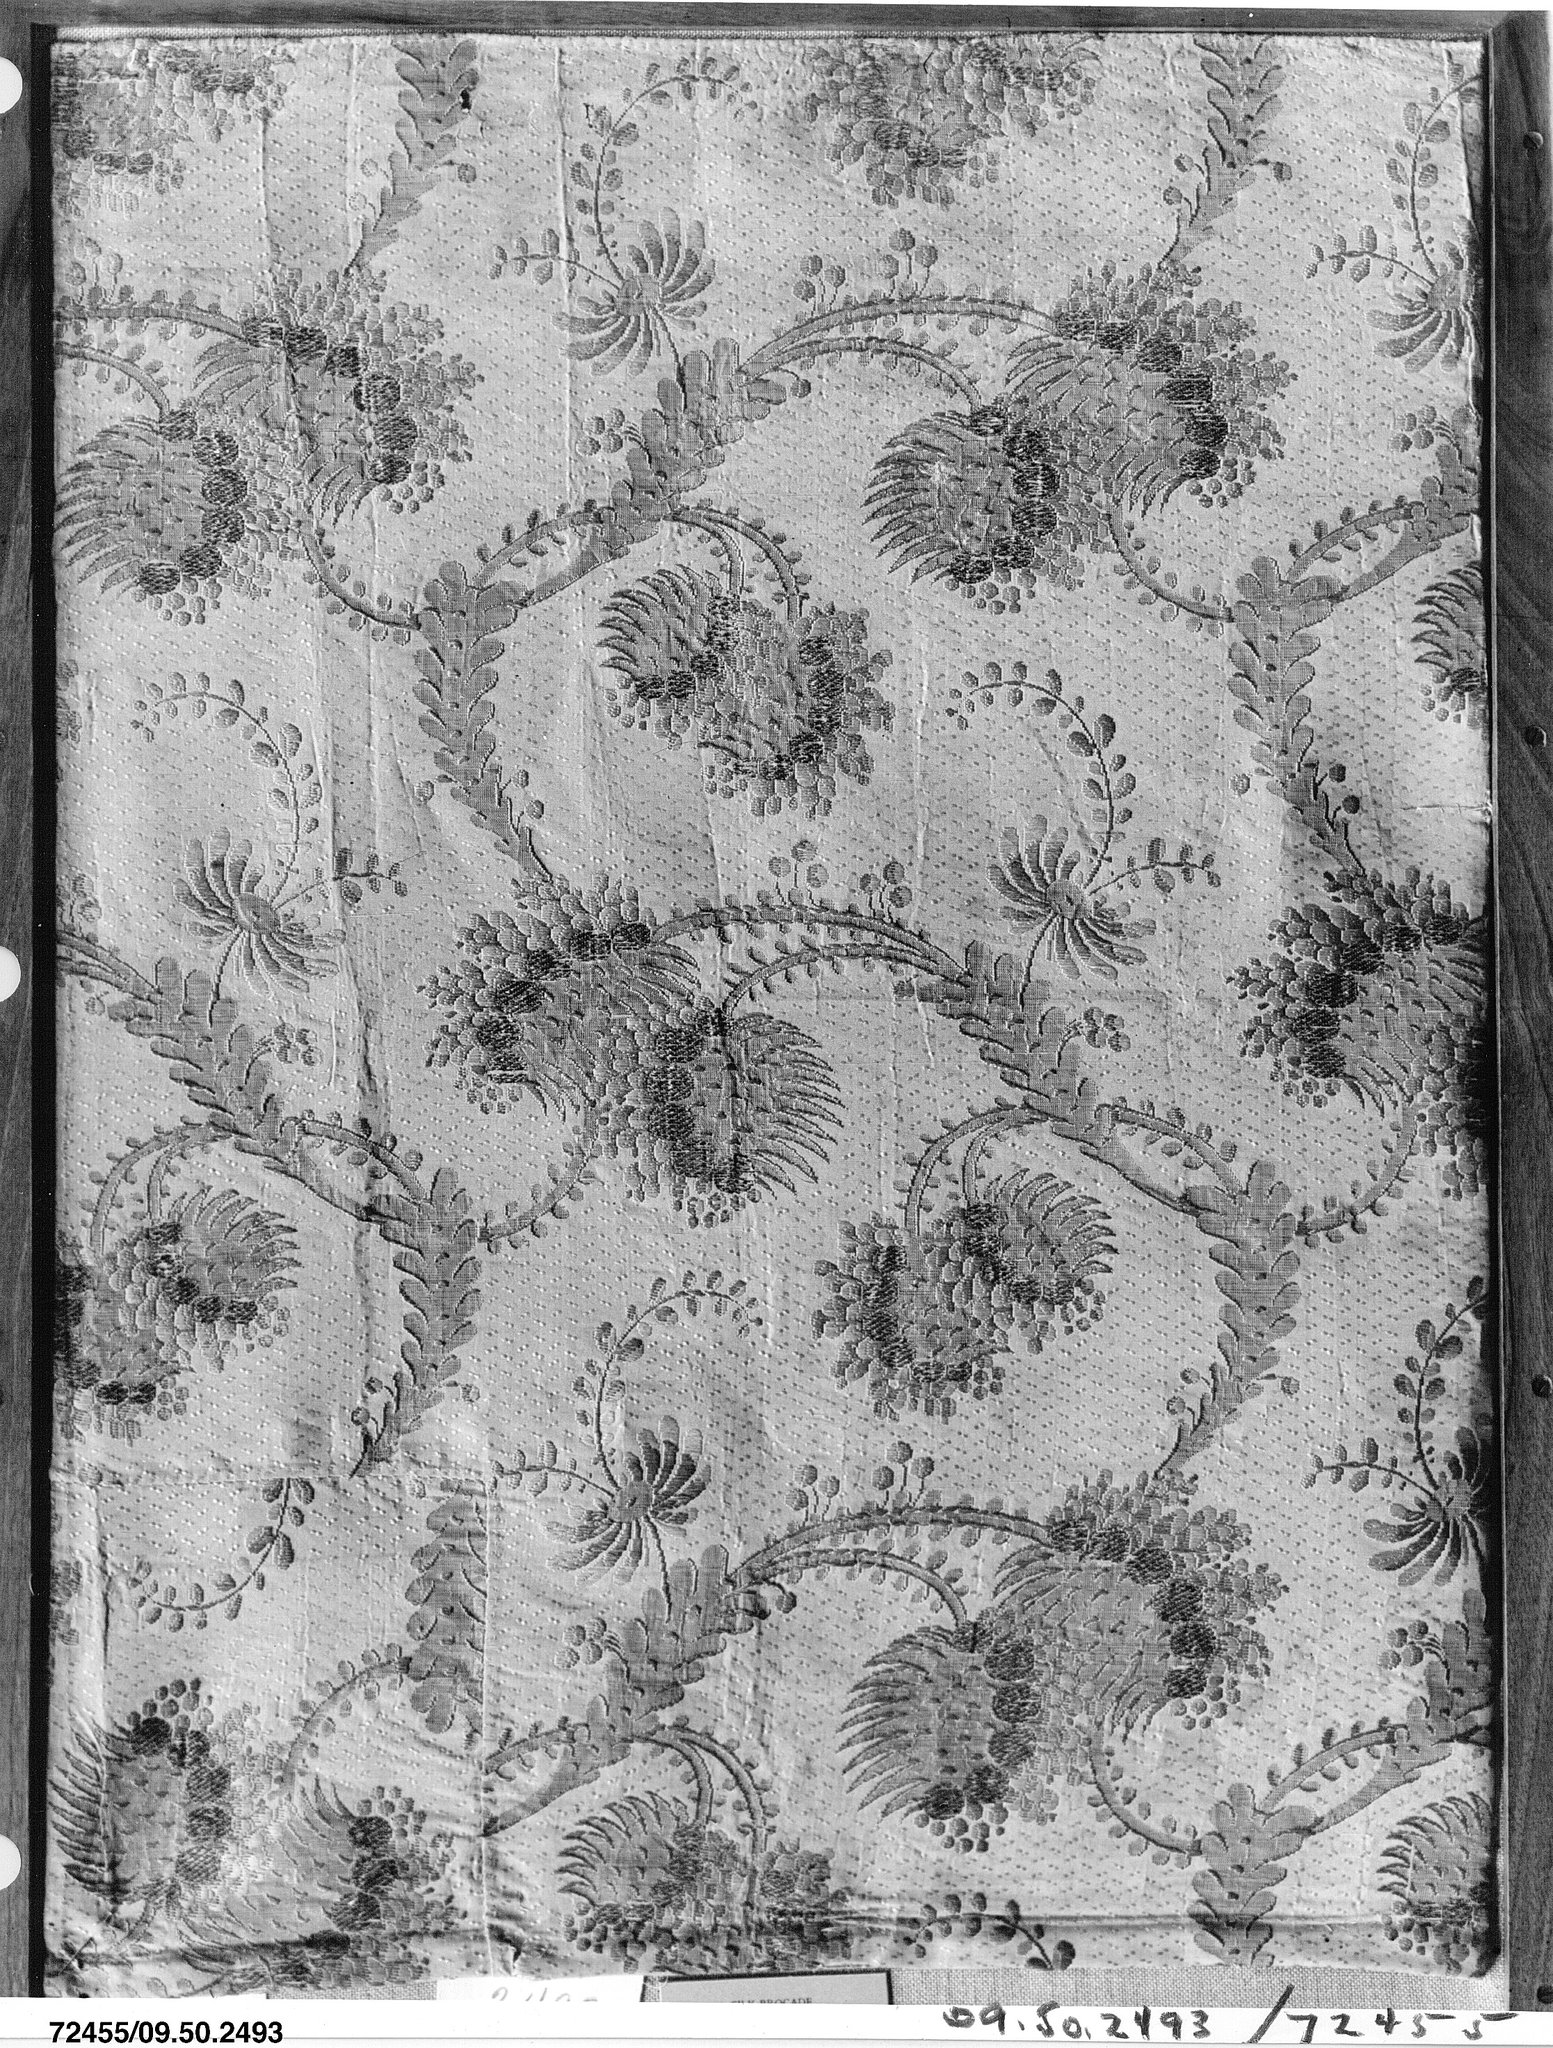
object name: piece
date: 1745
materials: metal thread, silk